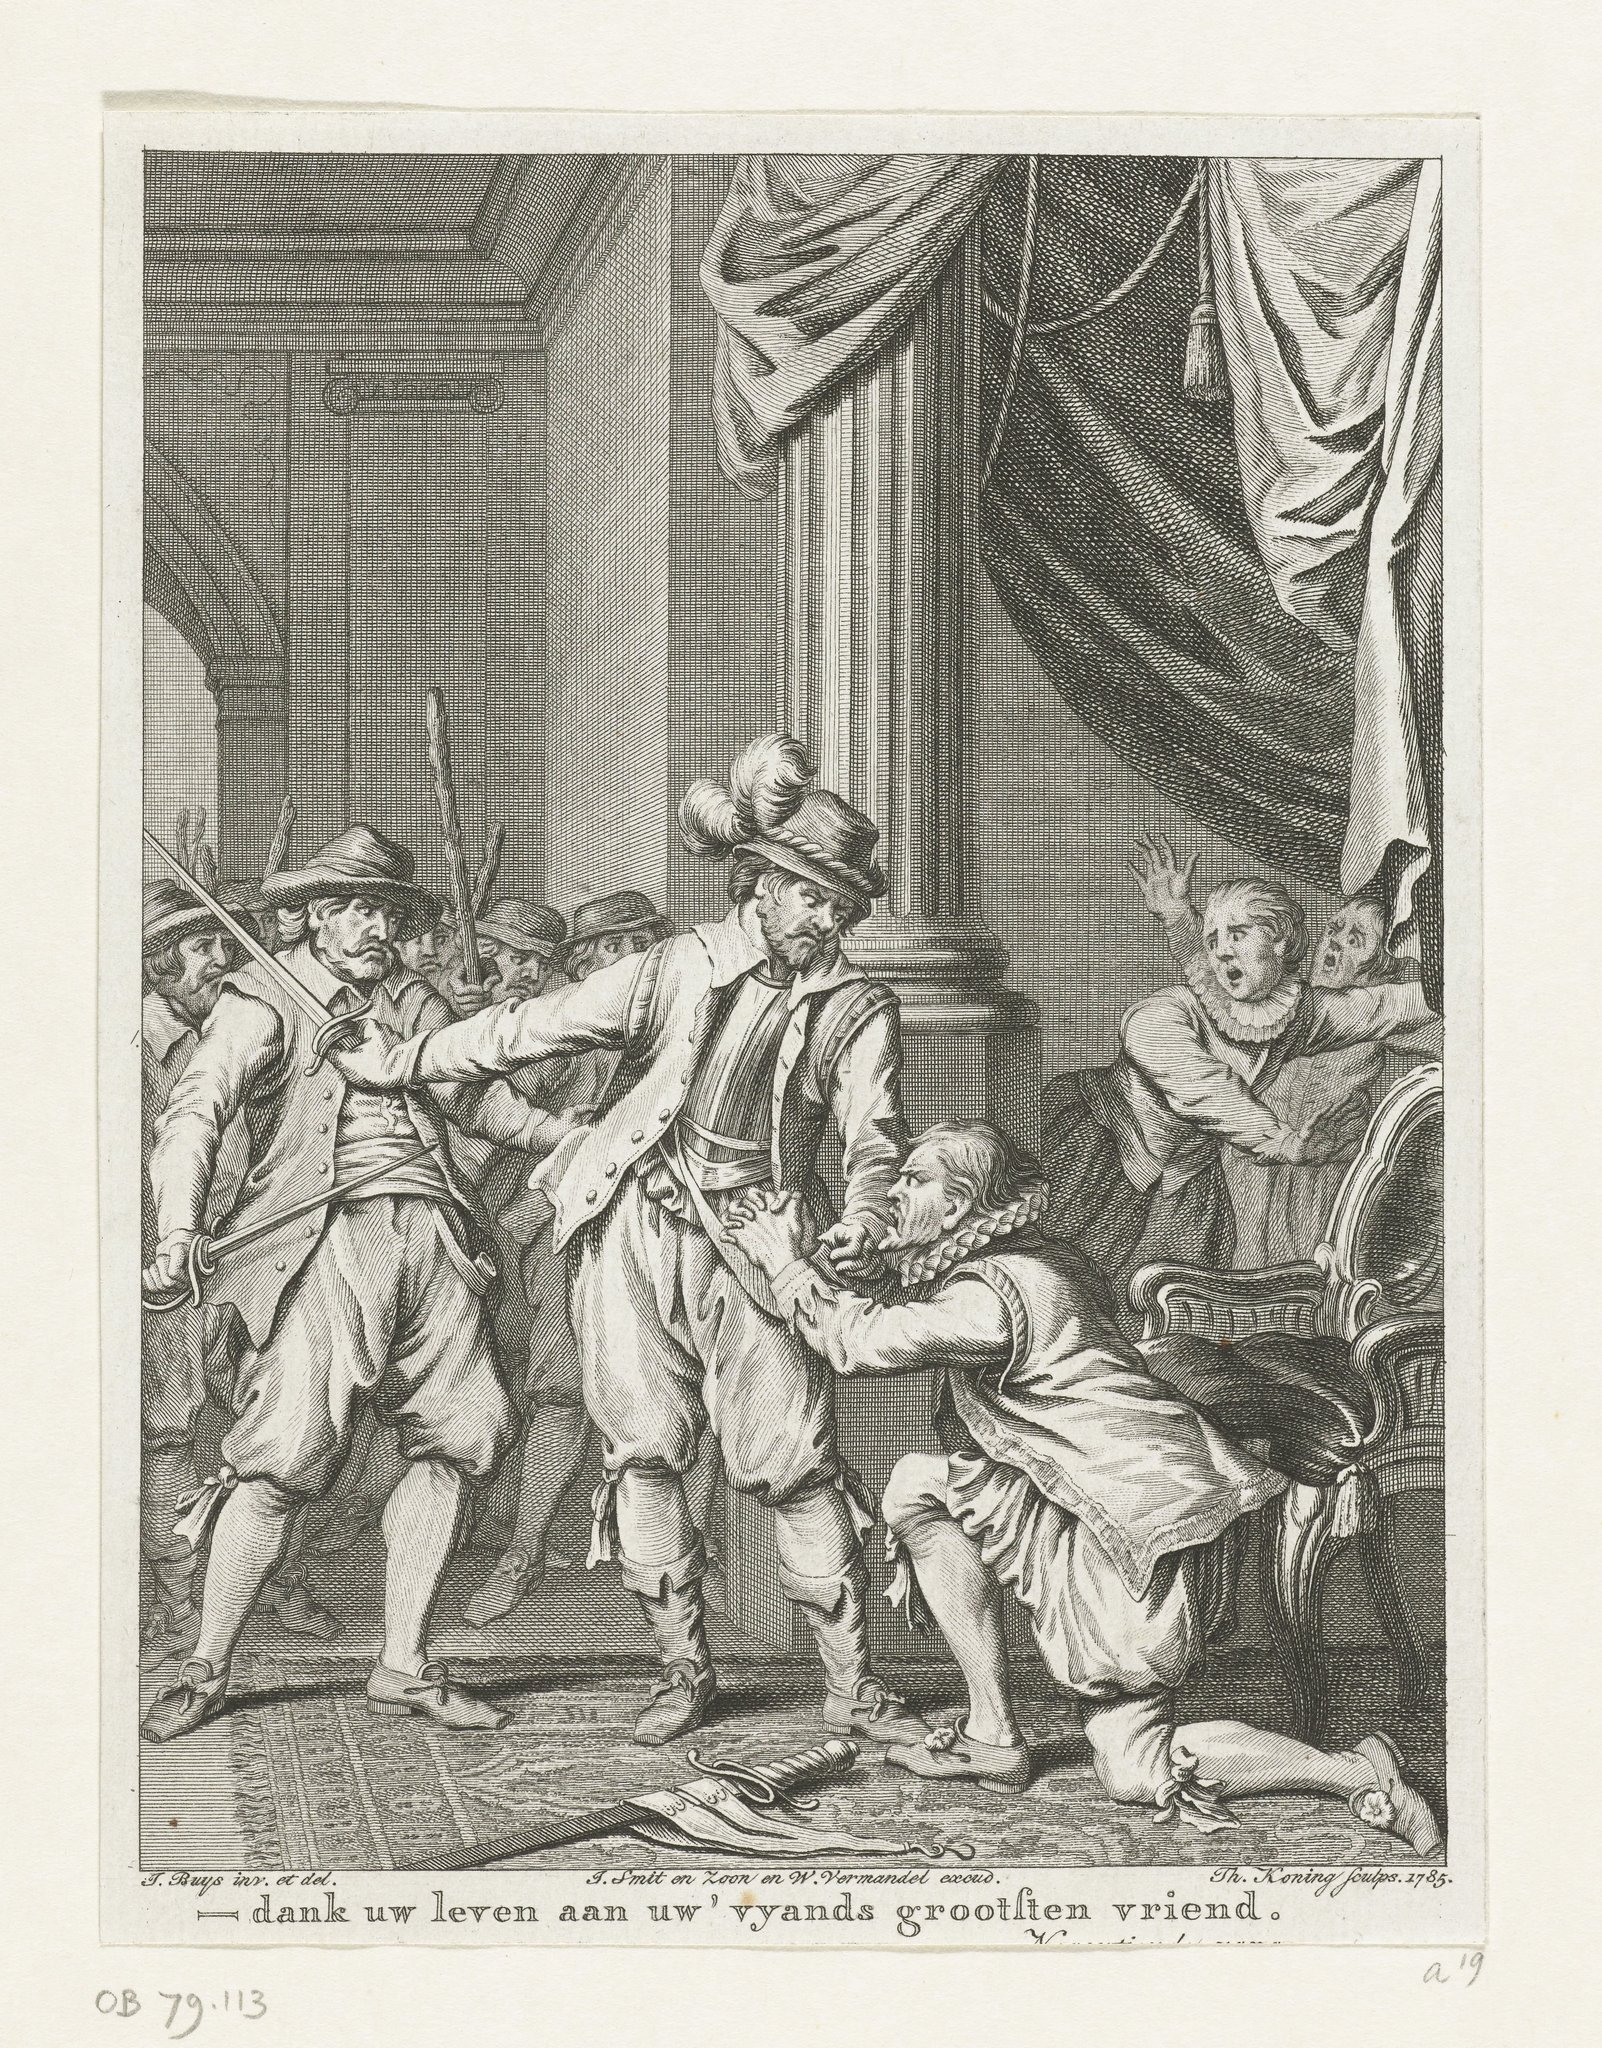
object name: print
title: Taferelen uit het leven van prins Willem I, 1568-1584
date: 1785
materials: paper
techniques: etching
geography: amsterdam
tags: utrecht, ghent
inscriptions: date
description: Illustratie voor: J. Nomsz, Willem de eerste, of de grondlegging der Nederlandsche vryheid. : In vier en twintig zangen, Erven van David Klippink, Amsterdam 1779. Staat met de letter.